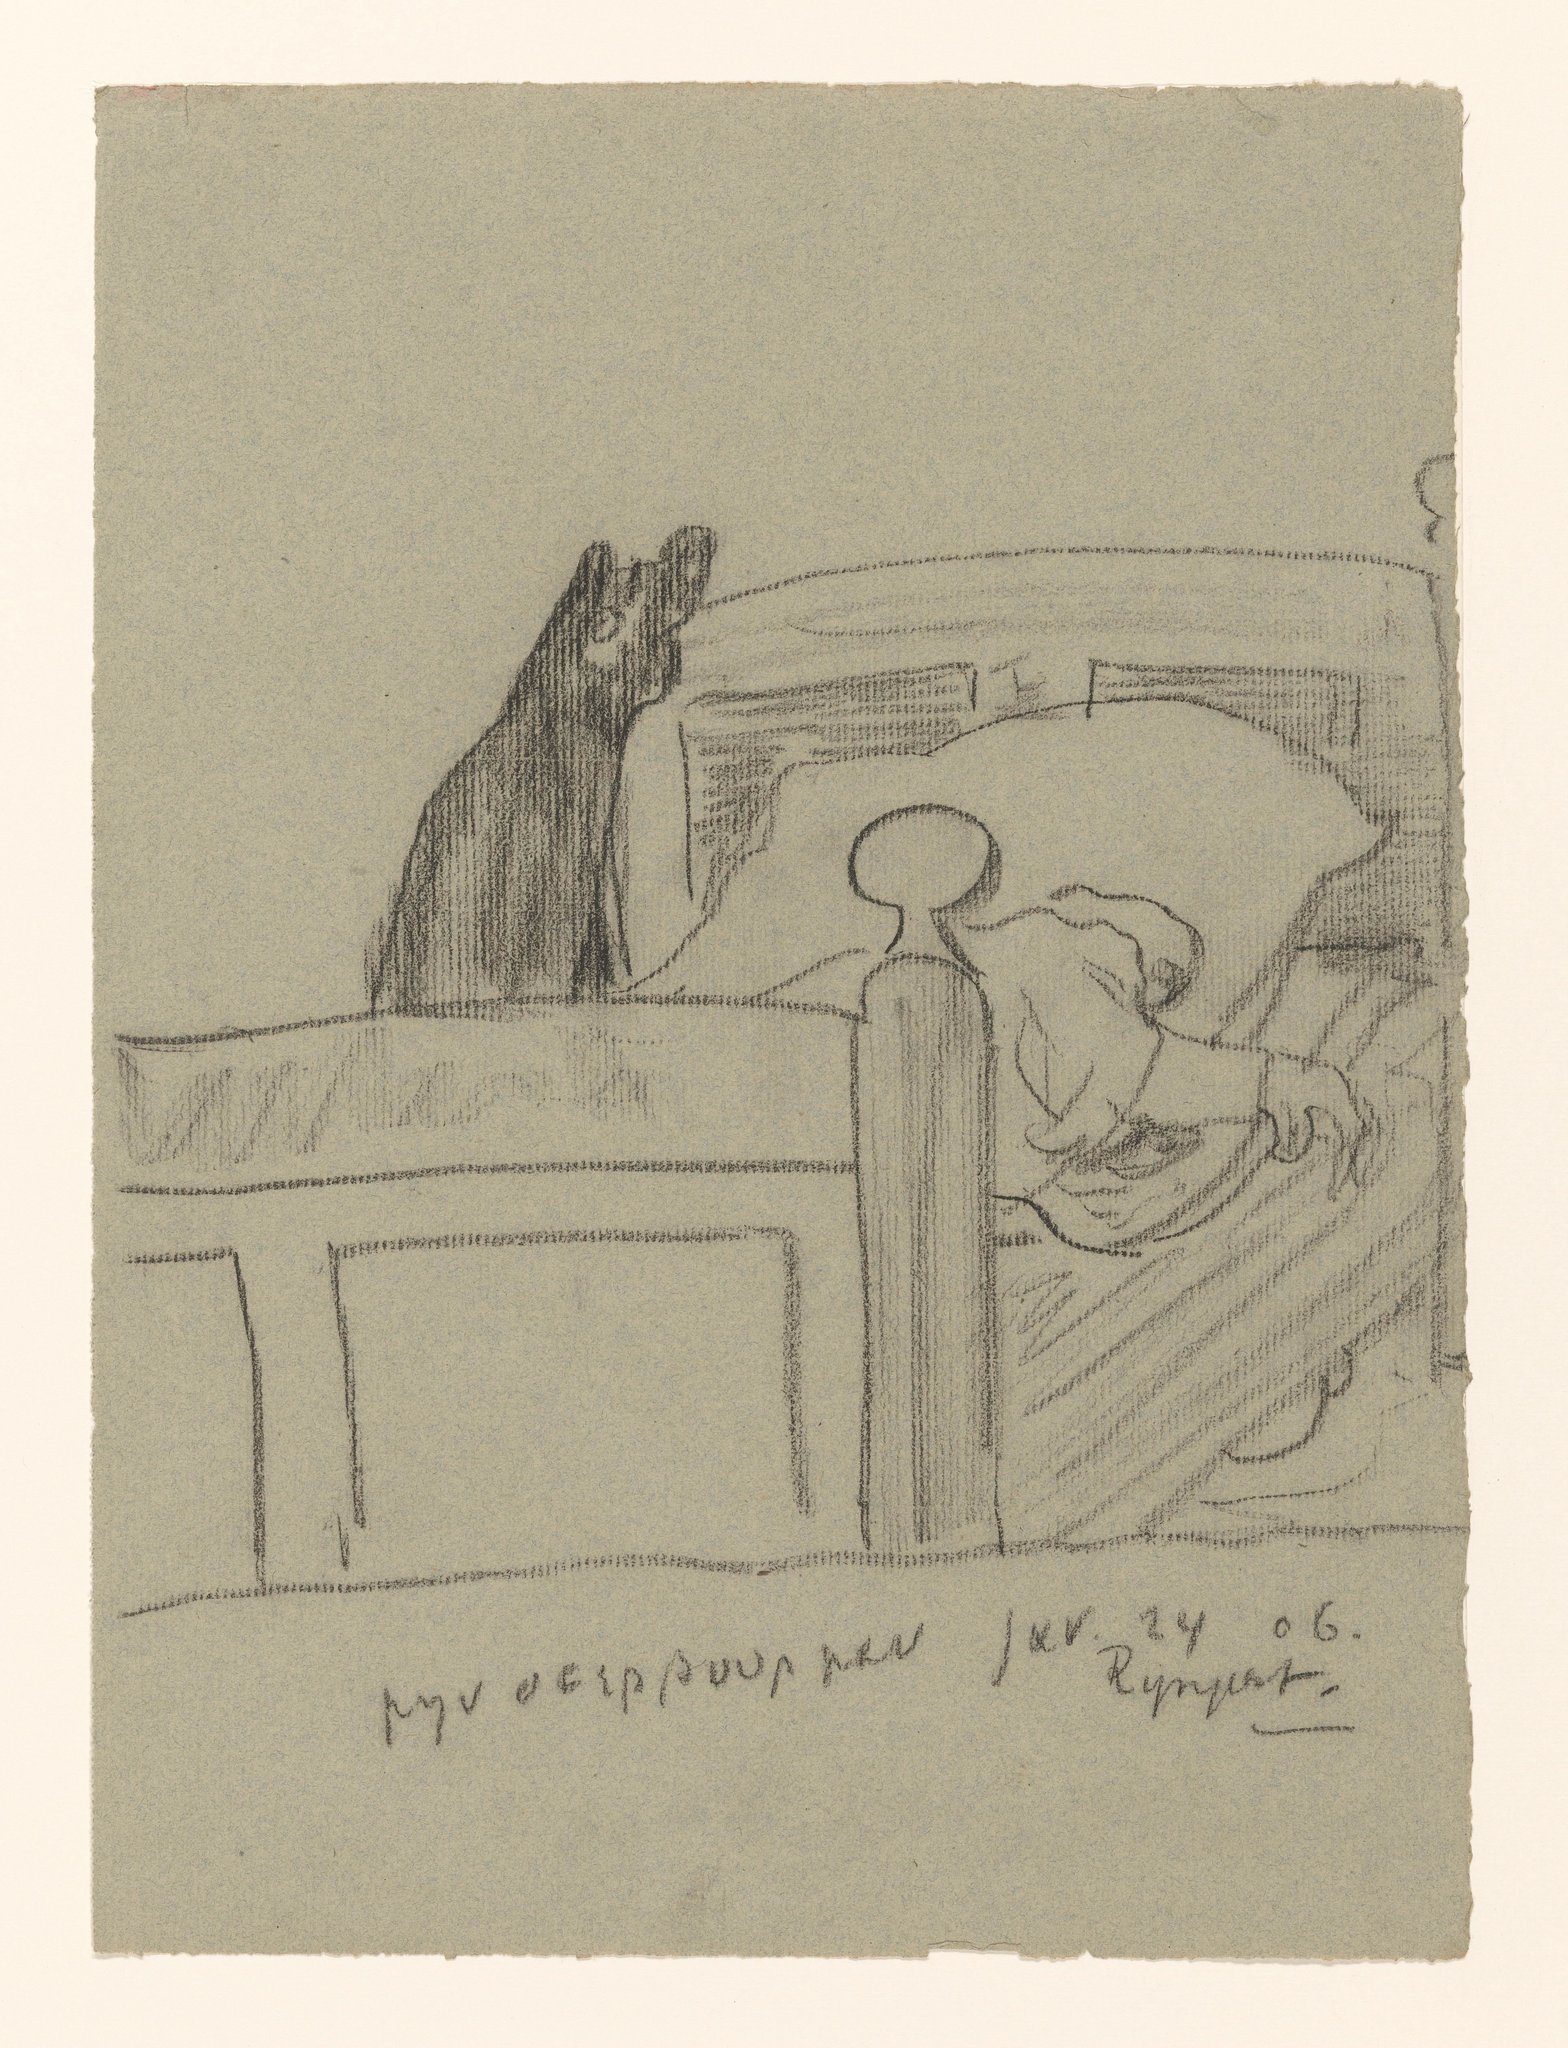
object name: drawing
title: Een zieke in zijn bed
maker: theo van hoytema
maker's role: draughtsman, painter, print maker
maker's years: 1863-1917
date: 1906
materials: chalk, paper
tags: sick-bed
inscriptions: date and inscription: ‘Mijn overbuurman. jan. 24 06 / Rijngeest’